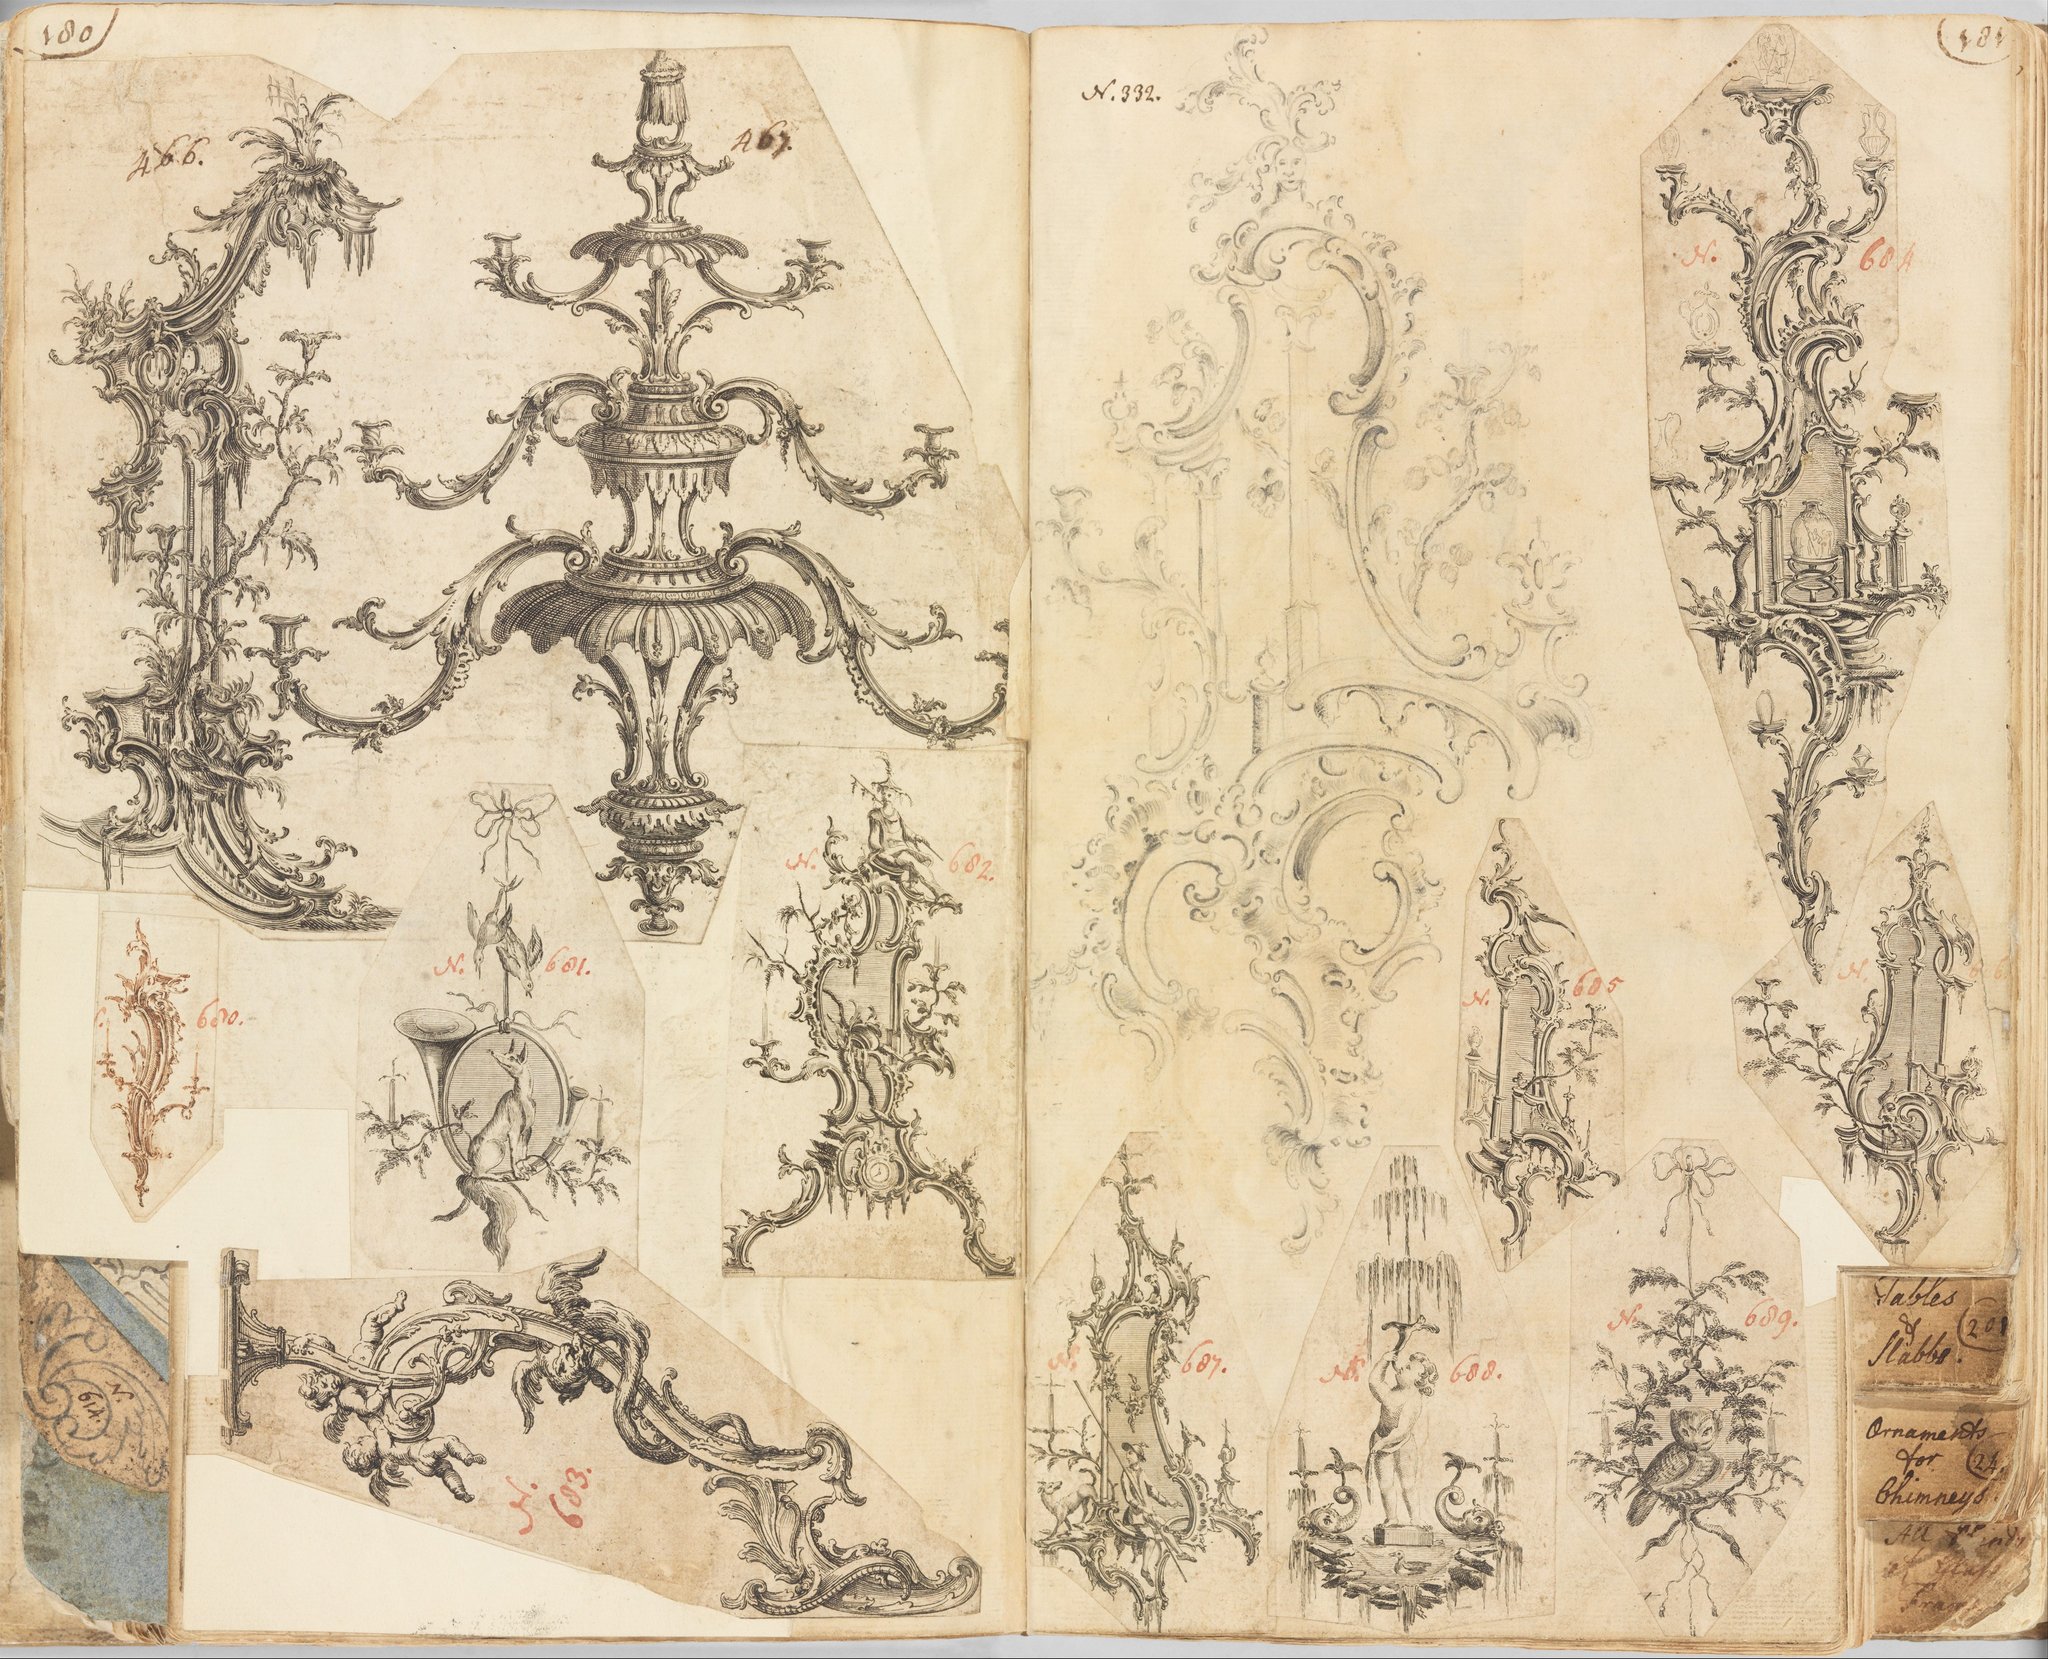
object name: album print ornament architecture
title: Scrapbook of Drawings and Prints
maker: gideon saint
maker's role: artist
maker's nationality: british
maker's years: 1729-1799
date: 1760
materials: ink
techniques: engraving, etching, pen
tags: ornament